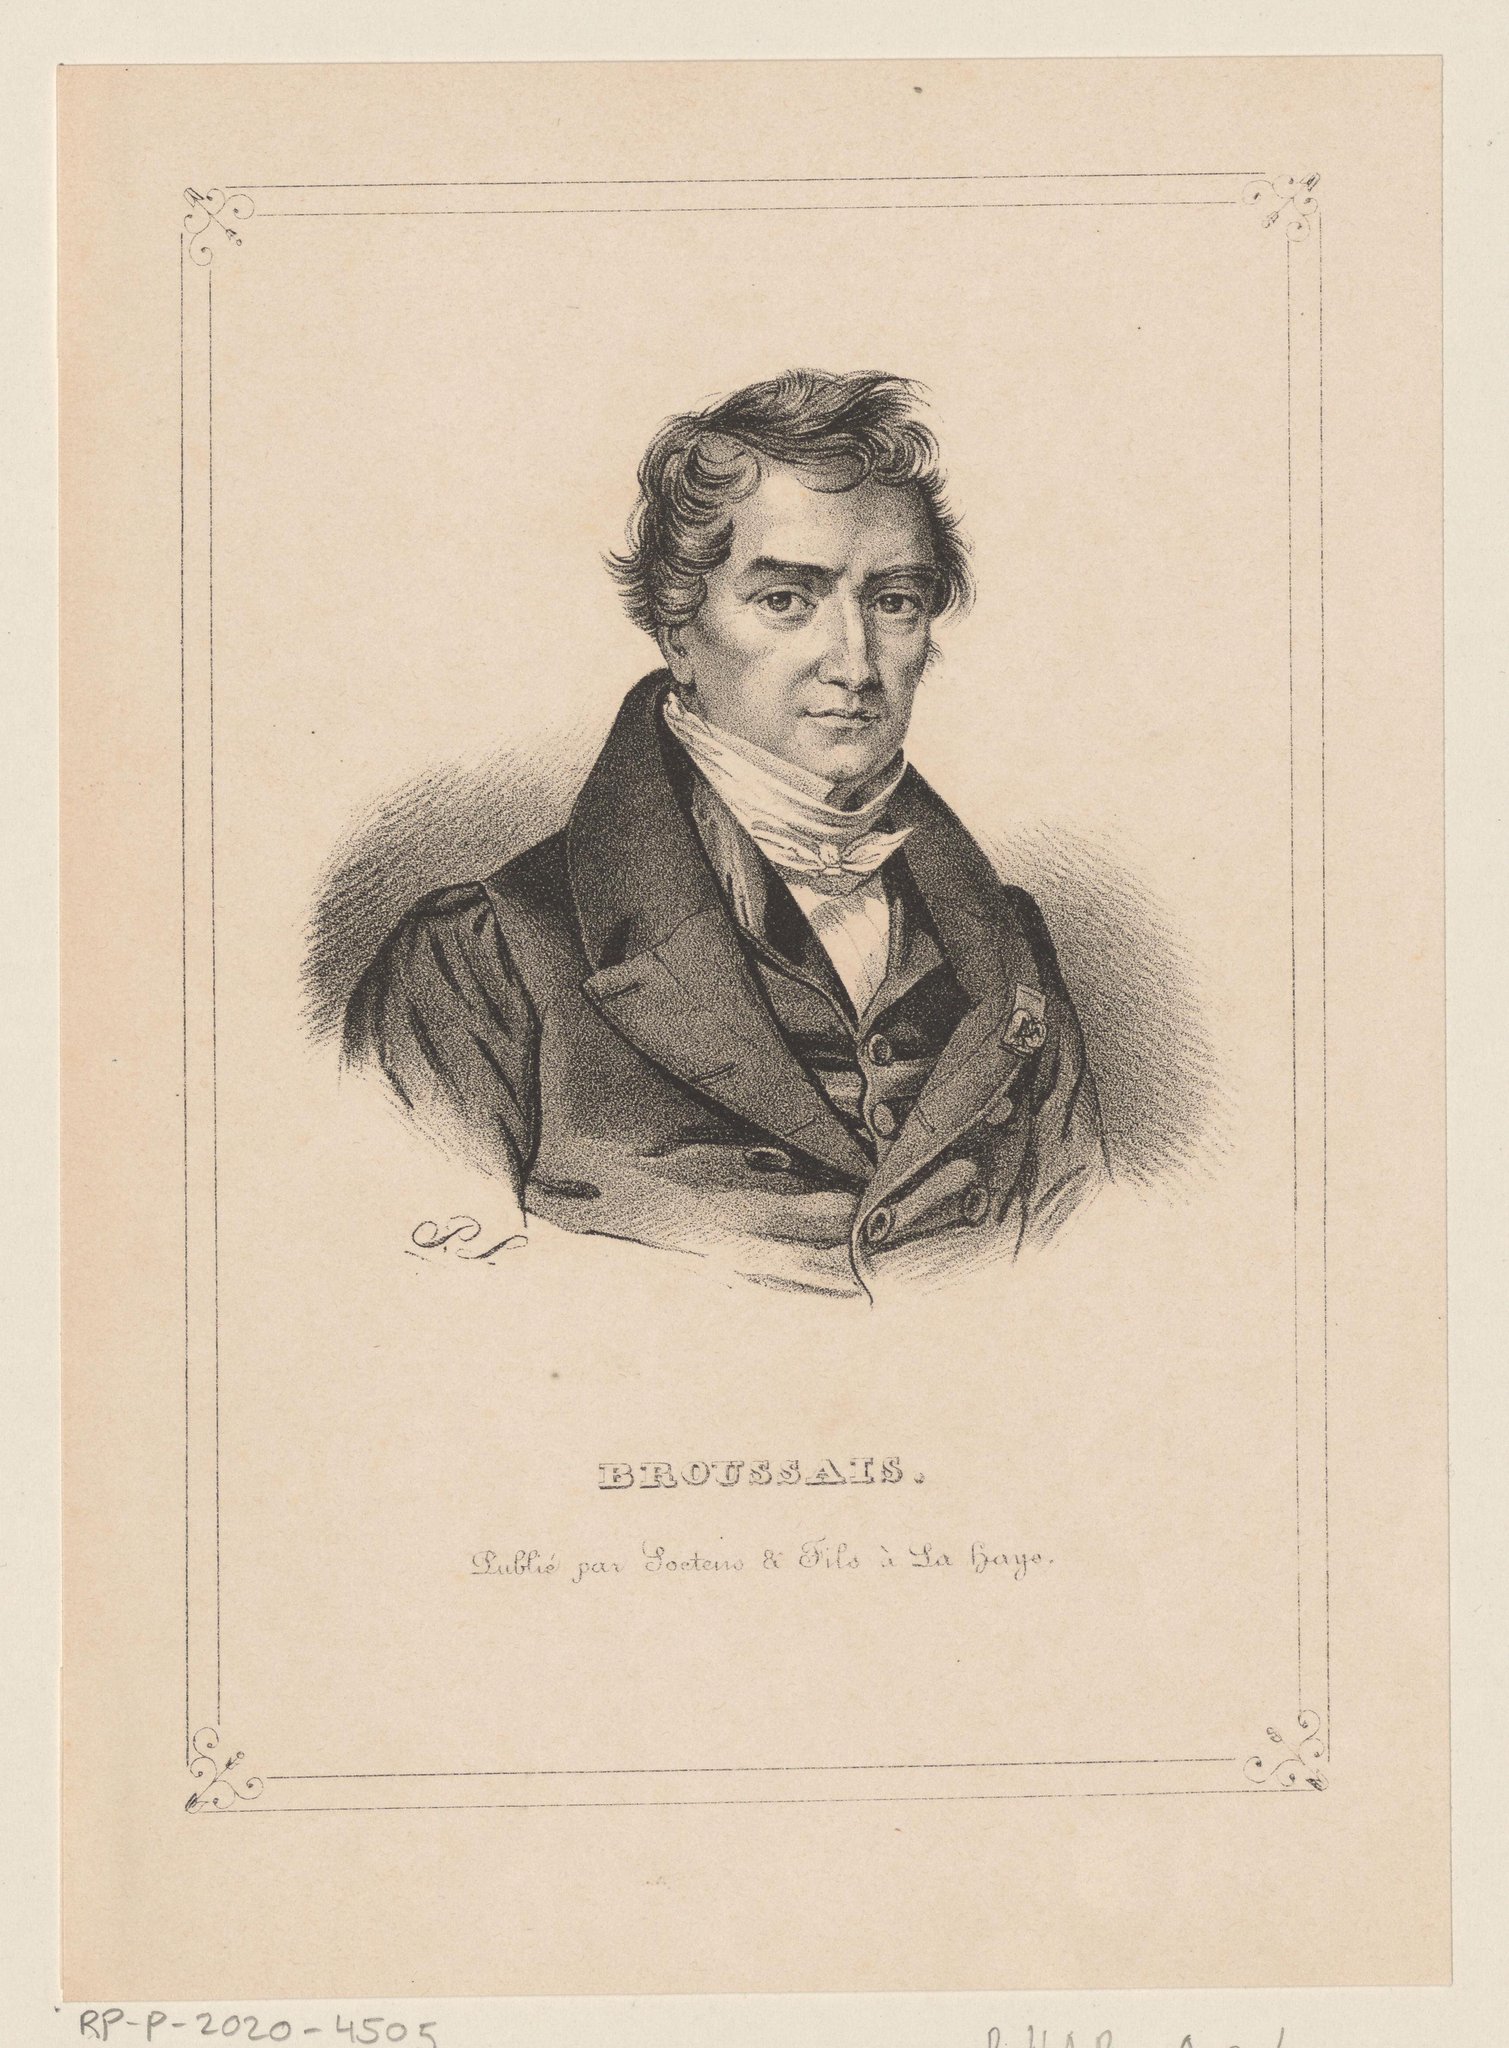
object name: print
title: Portret van François Broussais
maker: Anonymous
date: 1837-1840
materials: paper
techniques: lithograph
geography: the hague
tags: historical persons, physician, doctor